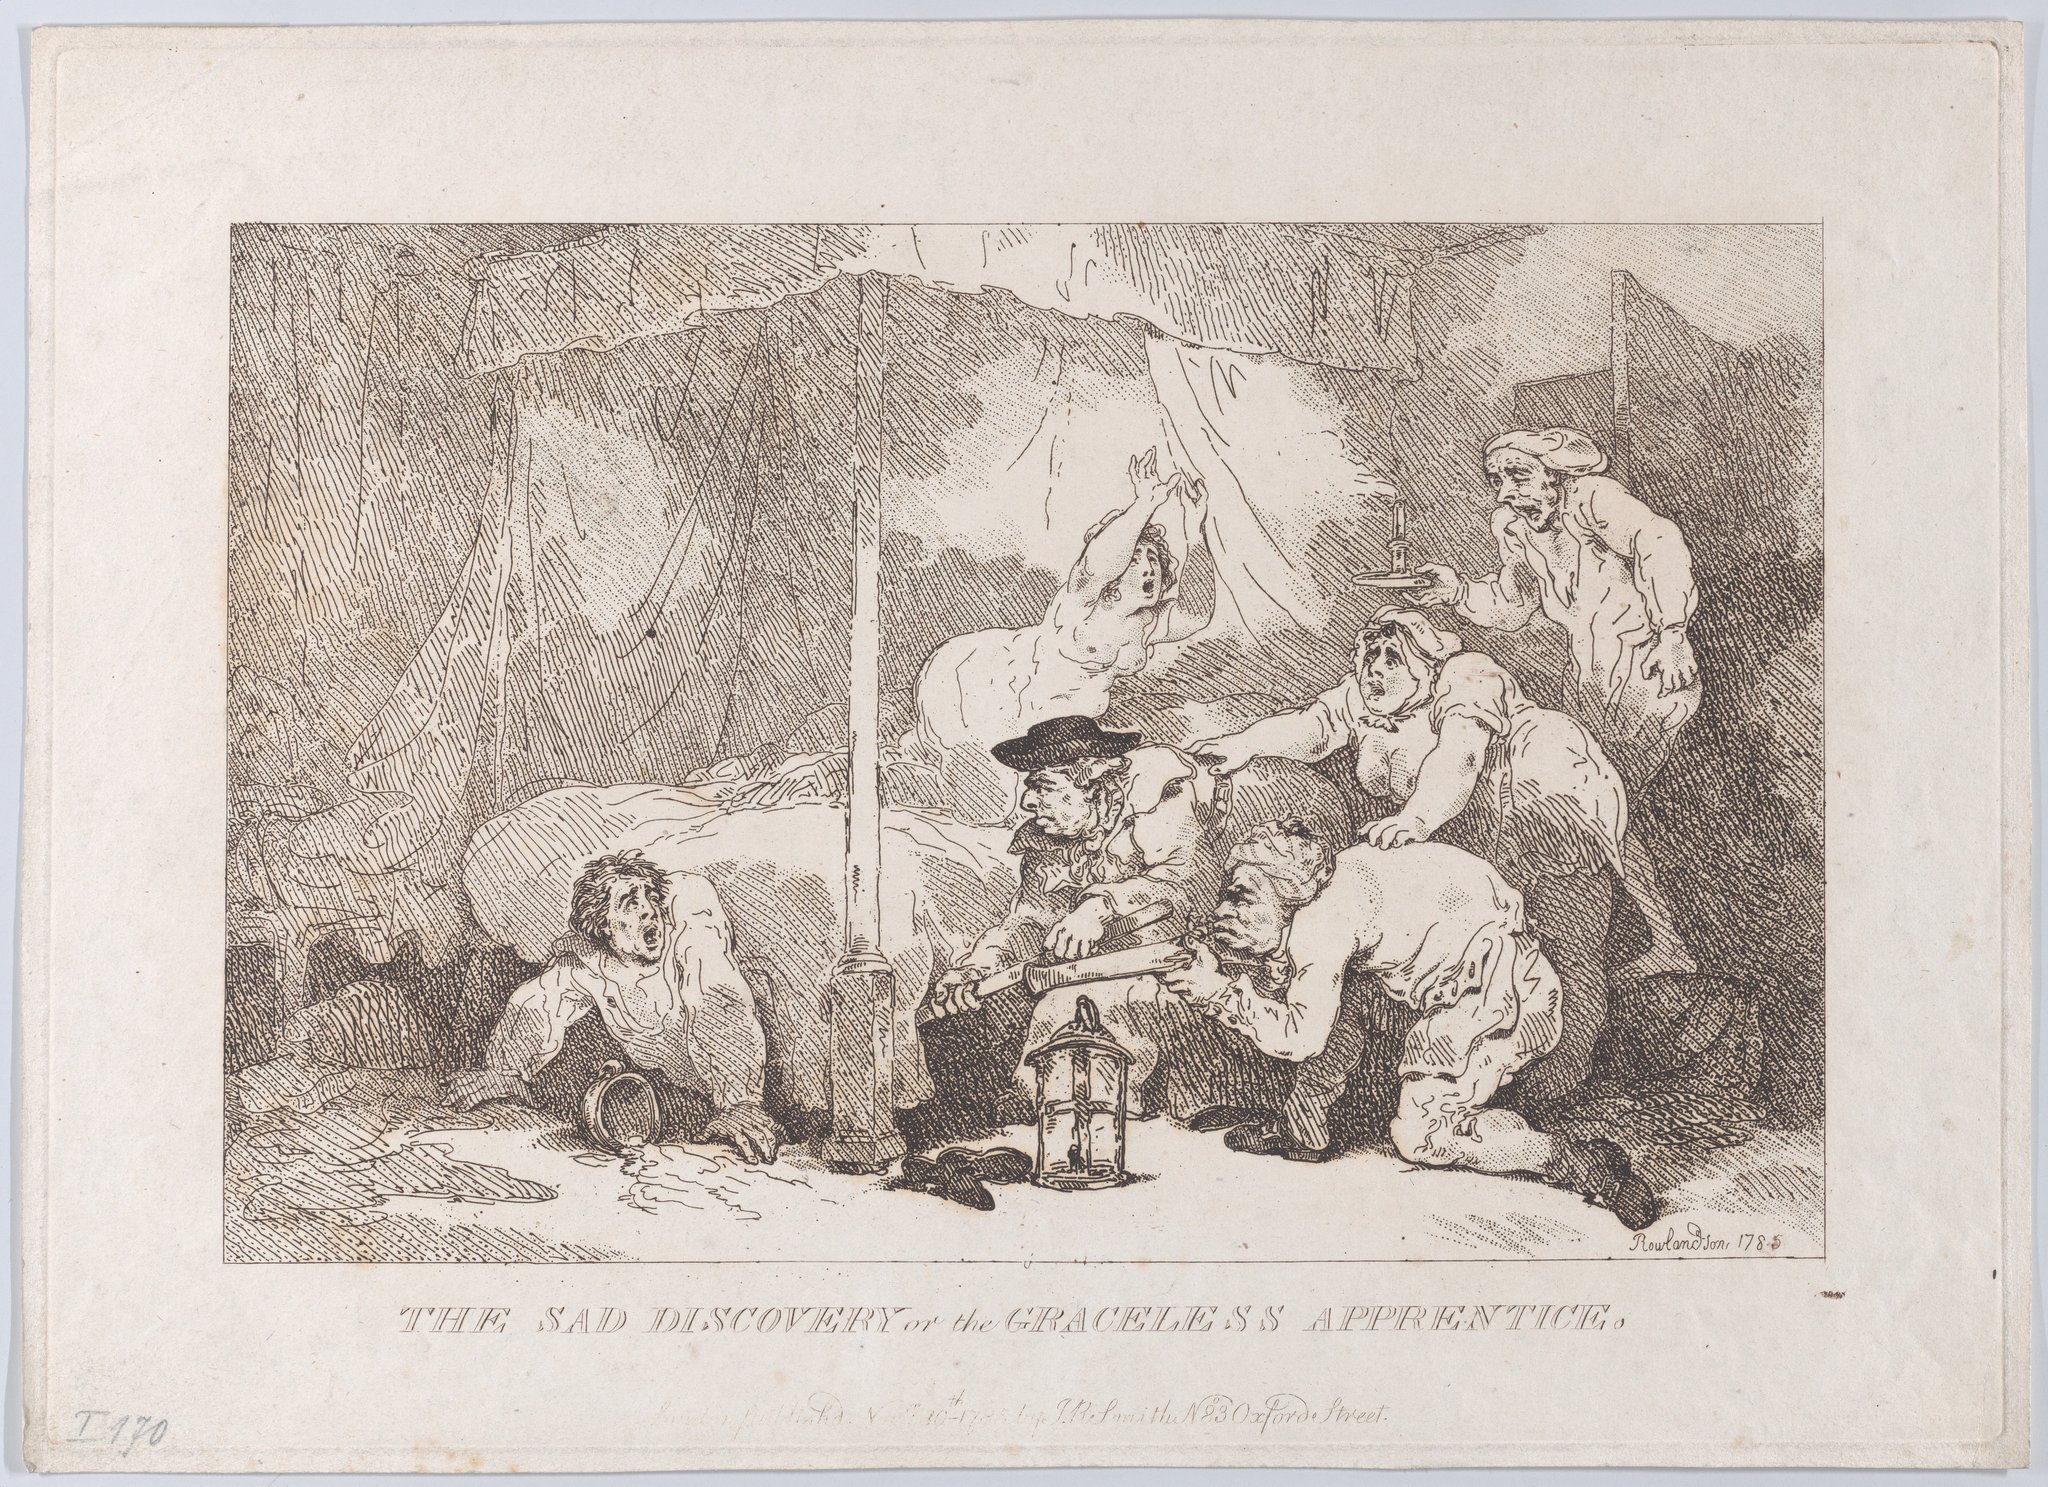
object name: print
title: The Sad Discovery of the Graceless Apprentice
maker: thomas rowlandson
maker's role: artist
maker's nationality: british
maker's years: 1757-1827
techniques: etching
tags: satire,bedrooms,men,women,beds